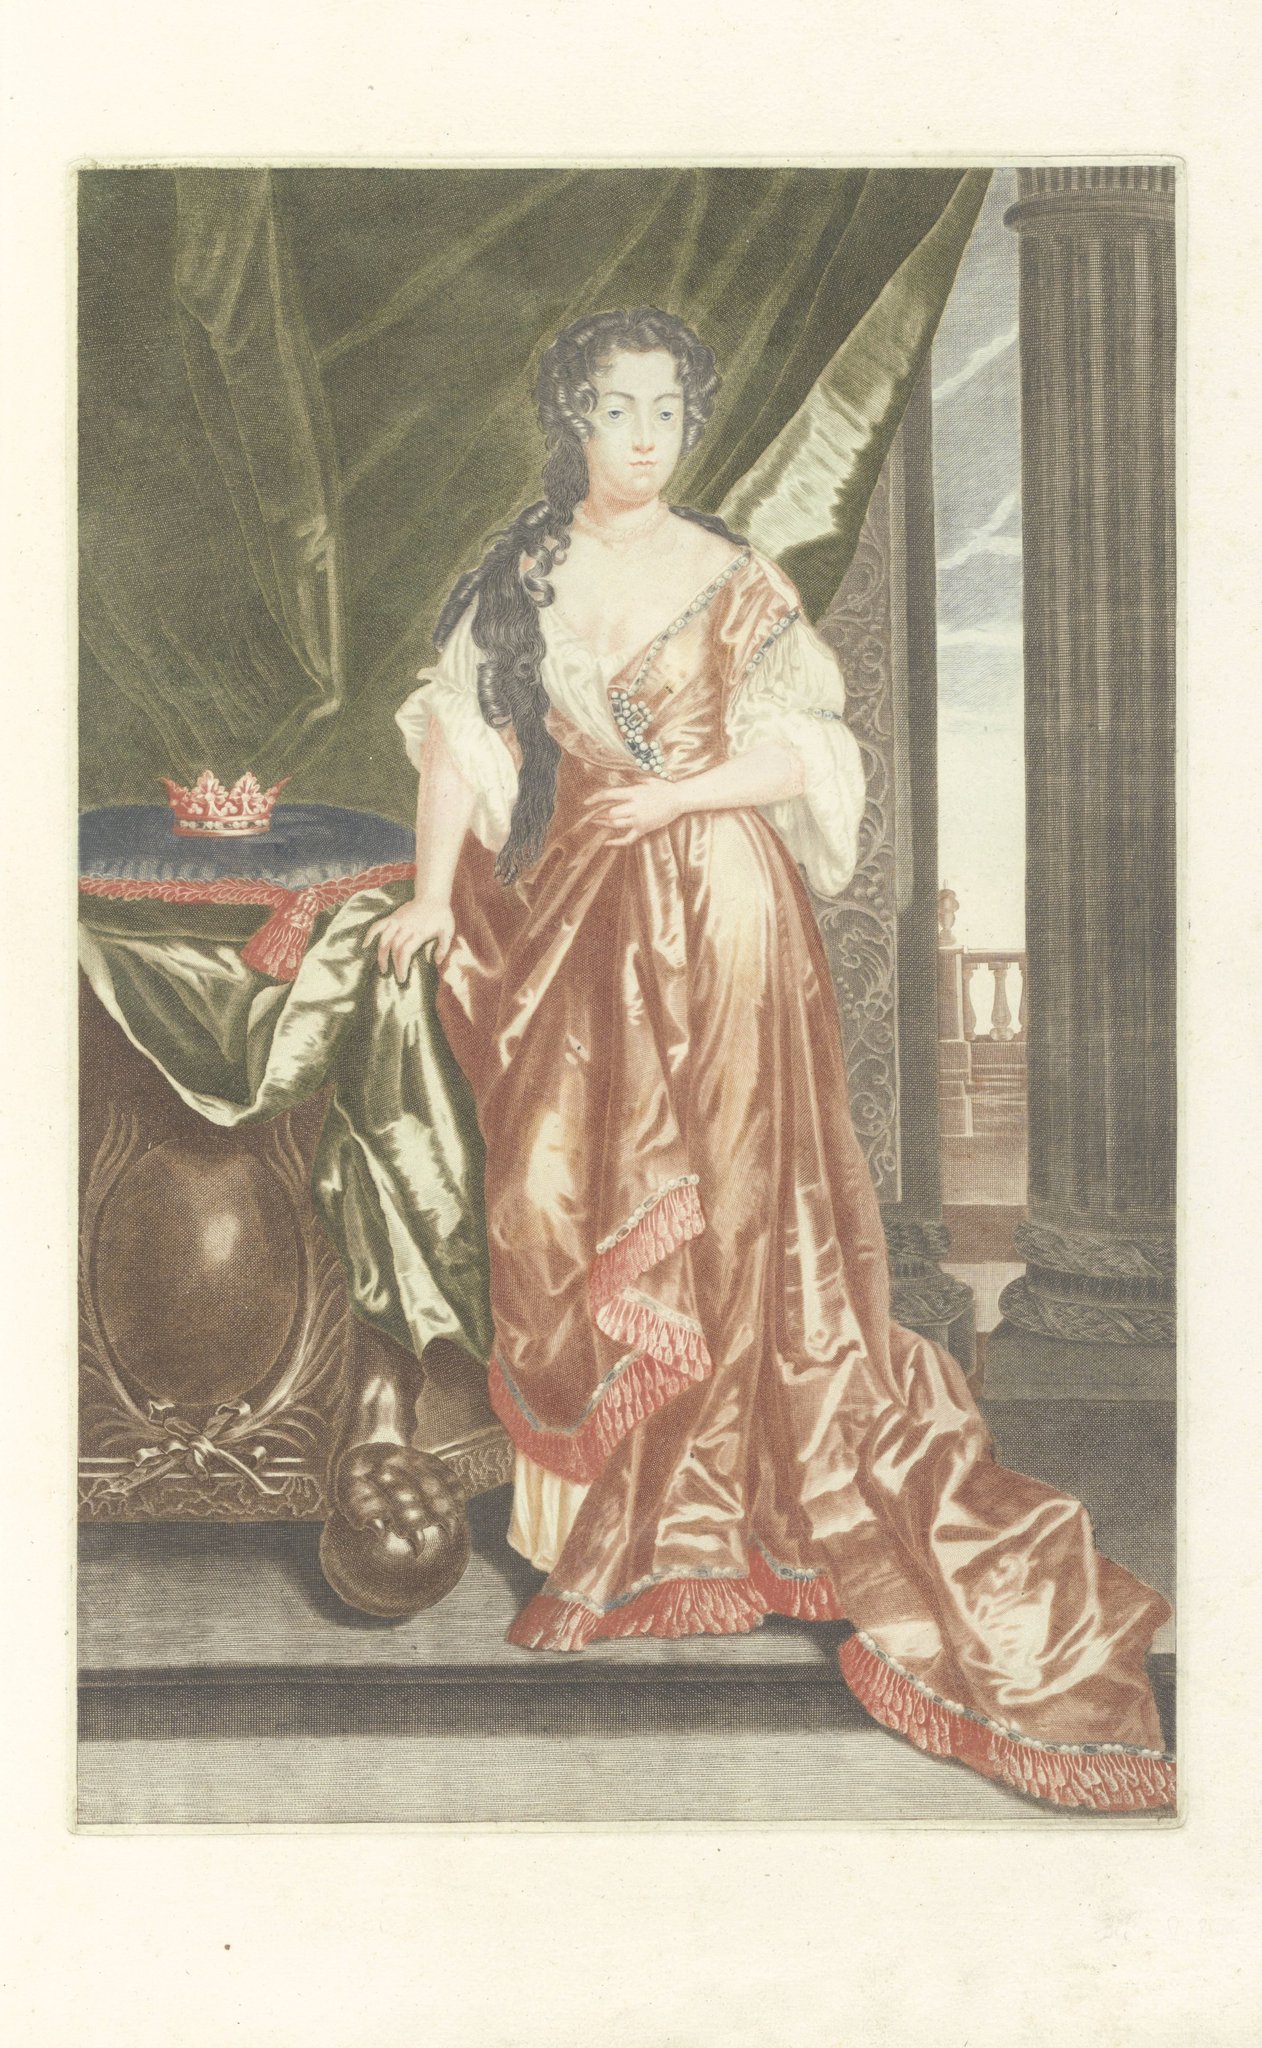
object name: album leaf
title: Portret van Louise de Kéroualle hertogin van Portsmouth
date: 1688-1698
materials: paper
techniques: engraving, etching, lithography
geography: netherlands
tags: hofdame, louise de kéroualle hertogin van portsmouth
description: Portret van Louise de Kéroualle hertogin van Portsmouth, maitresse van koning Karel II van Engeland, staande bij een tafel waarop een kroon ligt. Deze prent maakt deel uit van een album.